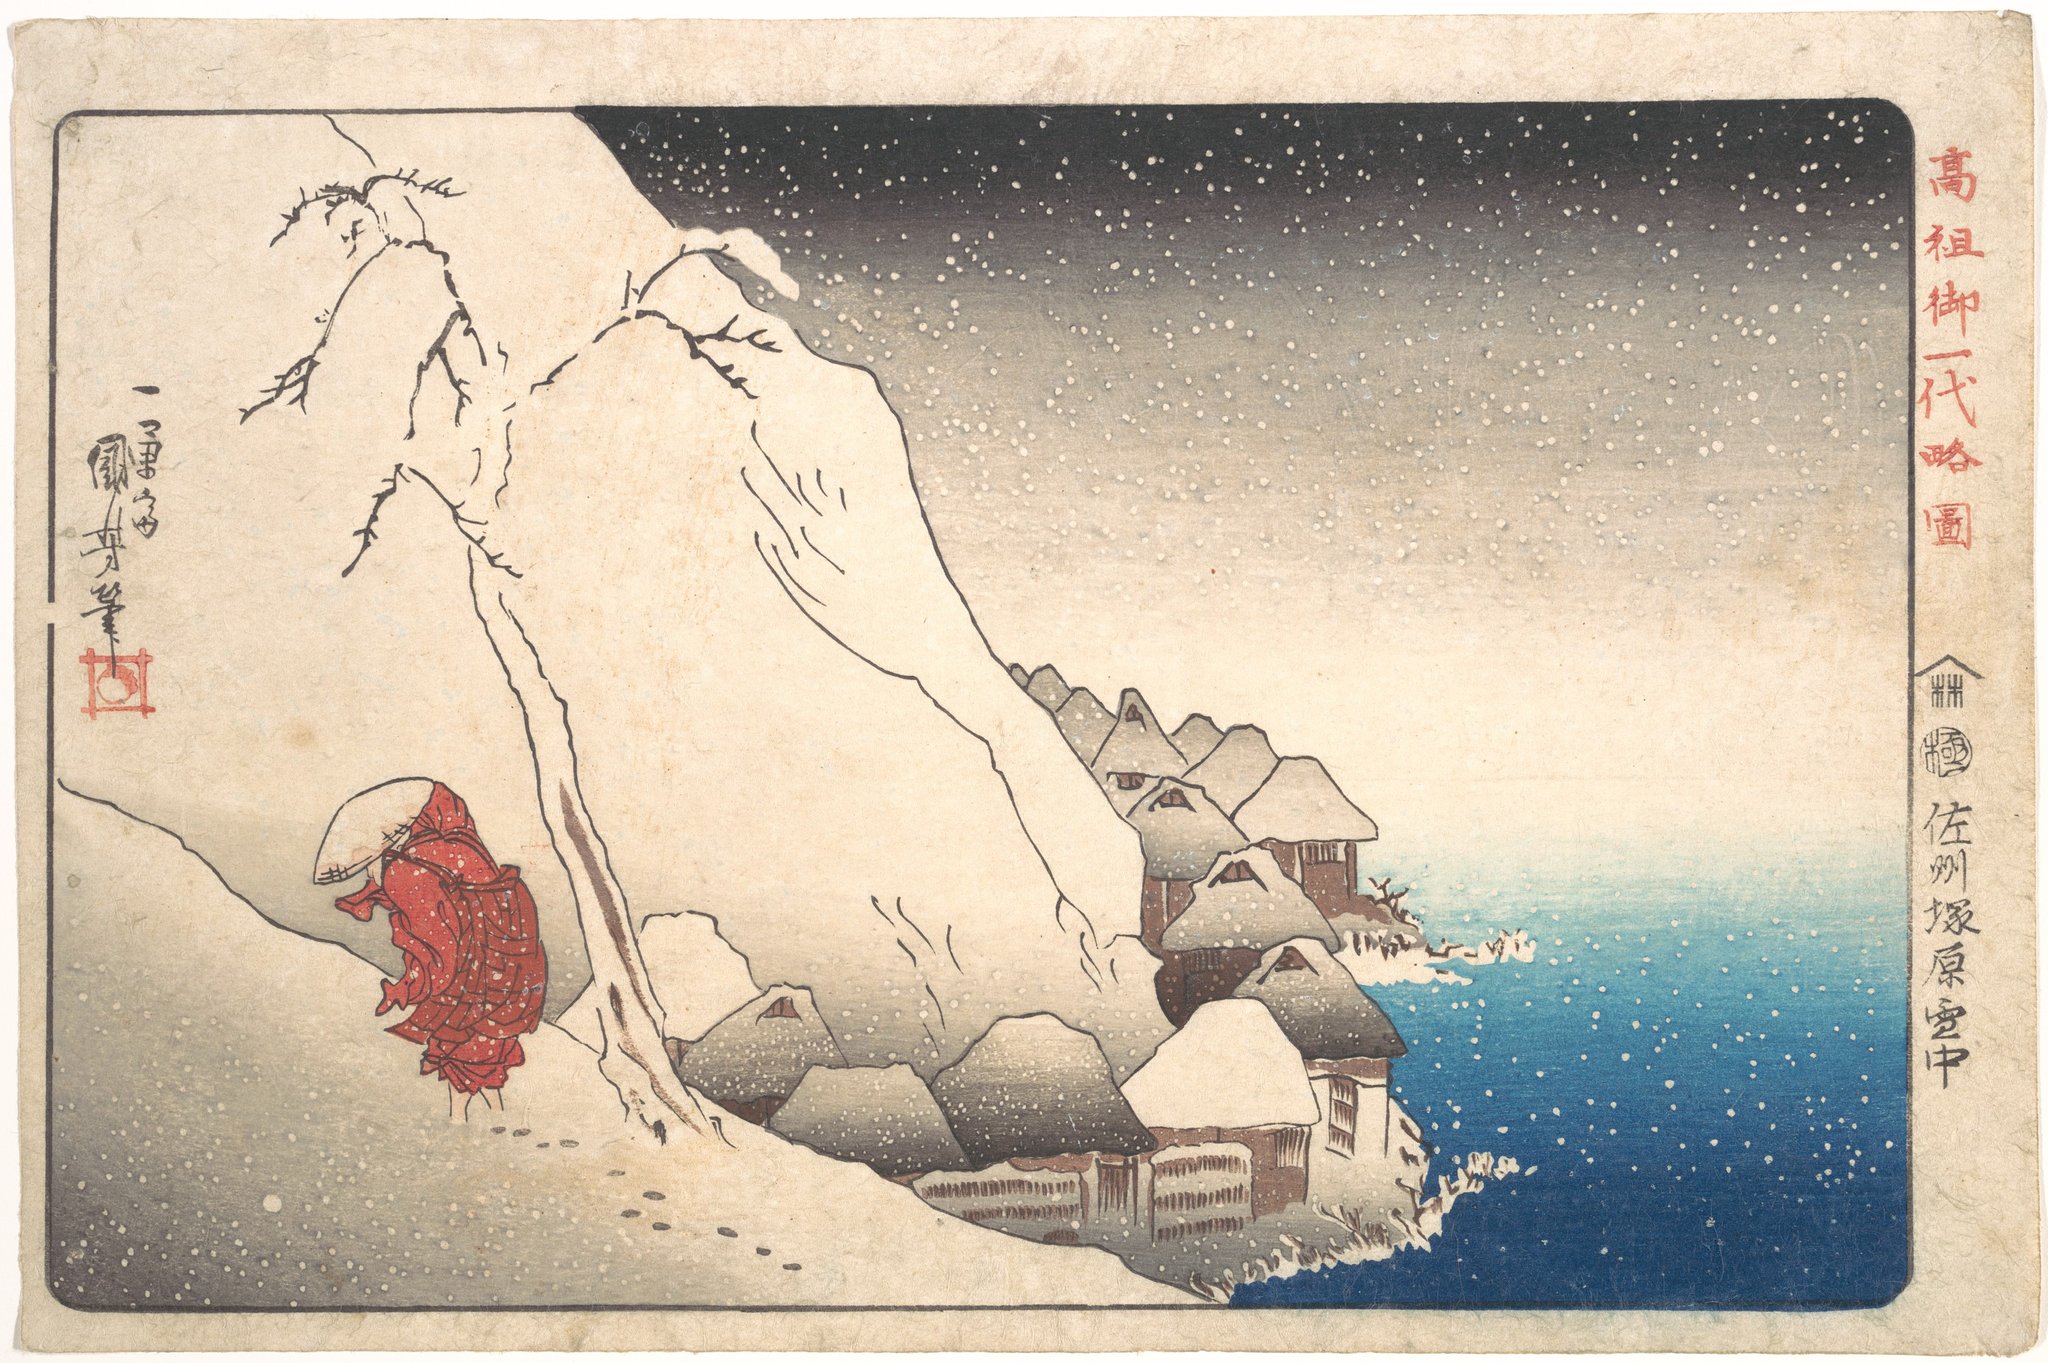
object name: woodblock print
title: Monk Nichiren in Exile on Sado Island, from the series "Illustration of Famous Monks"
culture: japanese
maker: utagawa kuniyoshi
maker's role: artist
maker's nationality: japanese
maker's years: 1797-1861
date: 1835-1836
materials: ink, paper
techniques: woodblock print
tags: human figures,houses,mountains,trees